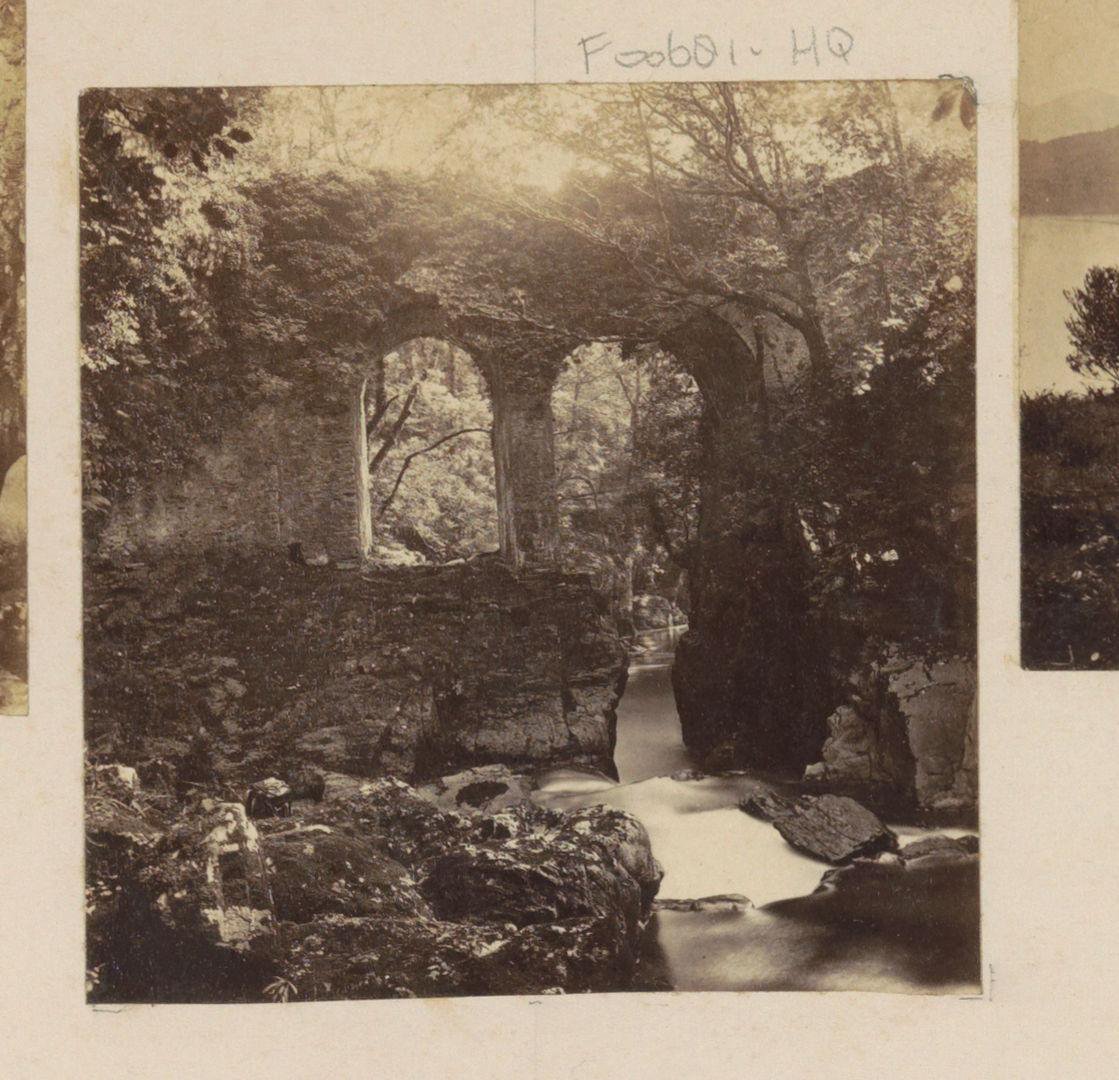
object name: photograph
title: Landschap met een oude overwoekerde brug over een rivier in Engeland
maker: Anonymous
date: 1850-1870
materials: paper, photographic support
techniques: albumen print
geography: england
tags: landscape with bridge, viaduct or aqueduct, england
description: Onderdeel van Album met foto's van bezienswaardigheden en landschappen in Engeland en van kunst.